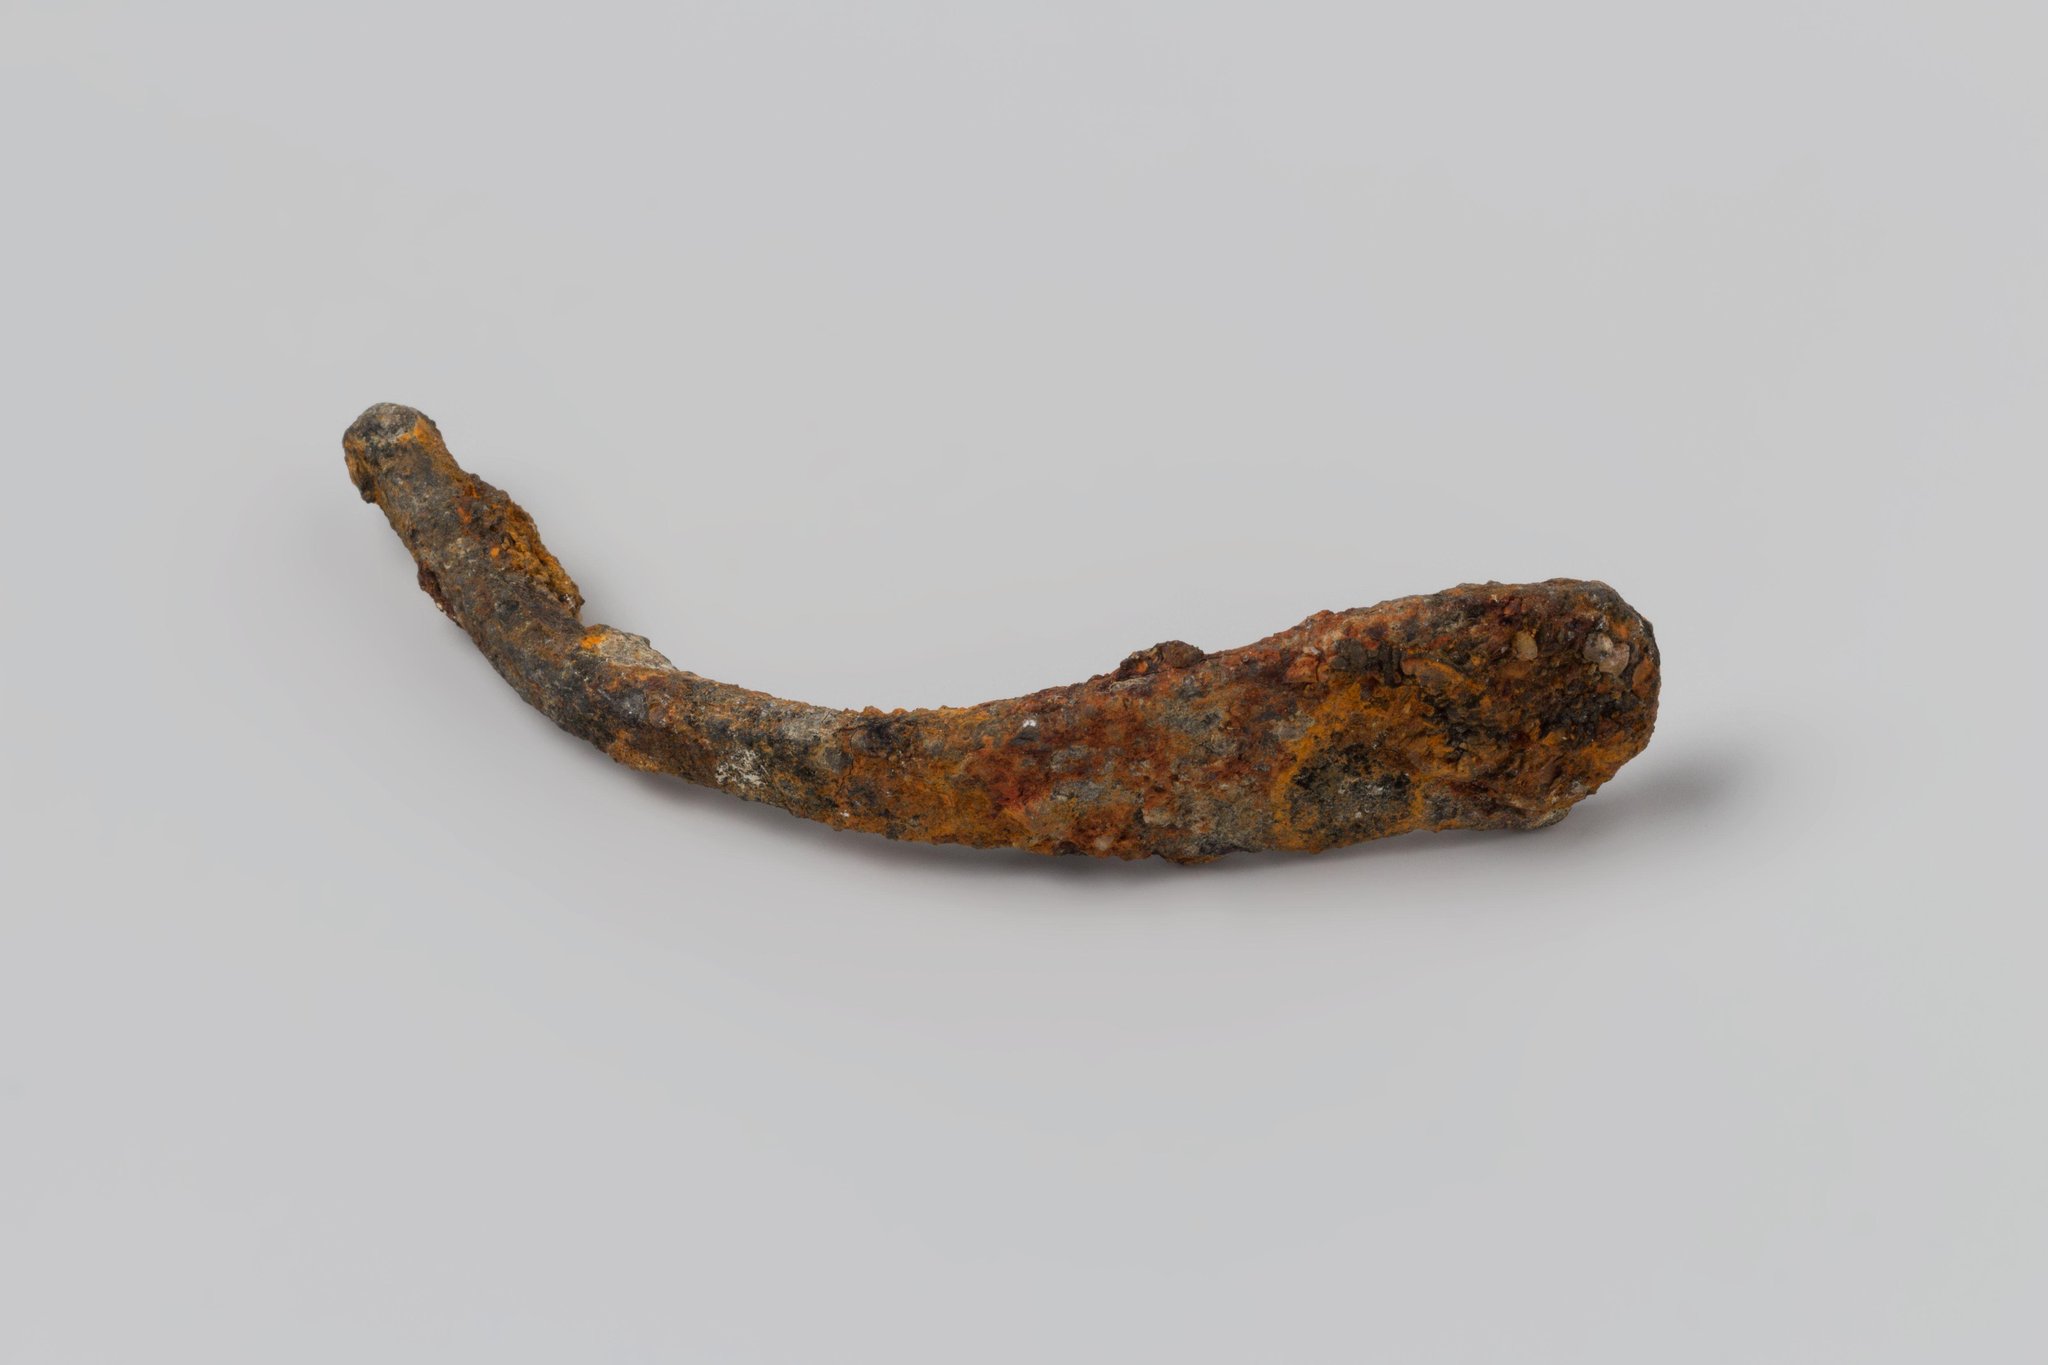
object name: spoon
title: Steel van vork of lepel uit het wrak van de Oost-Indiëvaarder Hollandia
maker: Anonymous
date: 1700-1743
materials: tin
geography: netherlands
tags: verenigde oostindische compagnie, hollandia (schip), annet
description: Cutlery, fragment: stem of fork or spoon; fragm, encrusted, id. NG 1980-27H67.